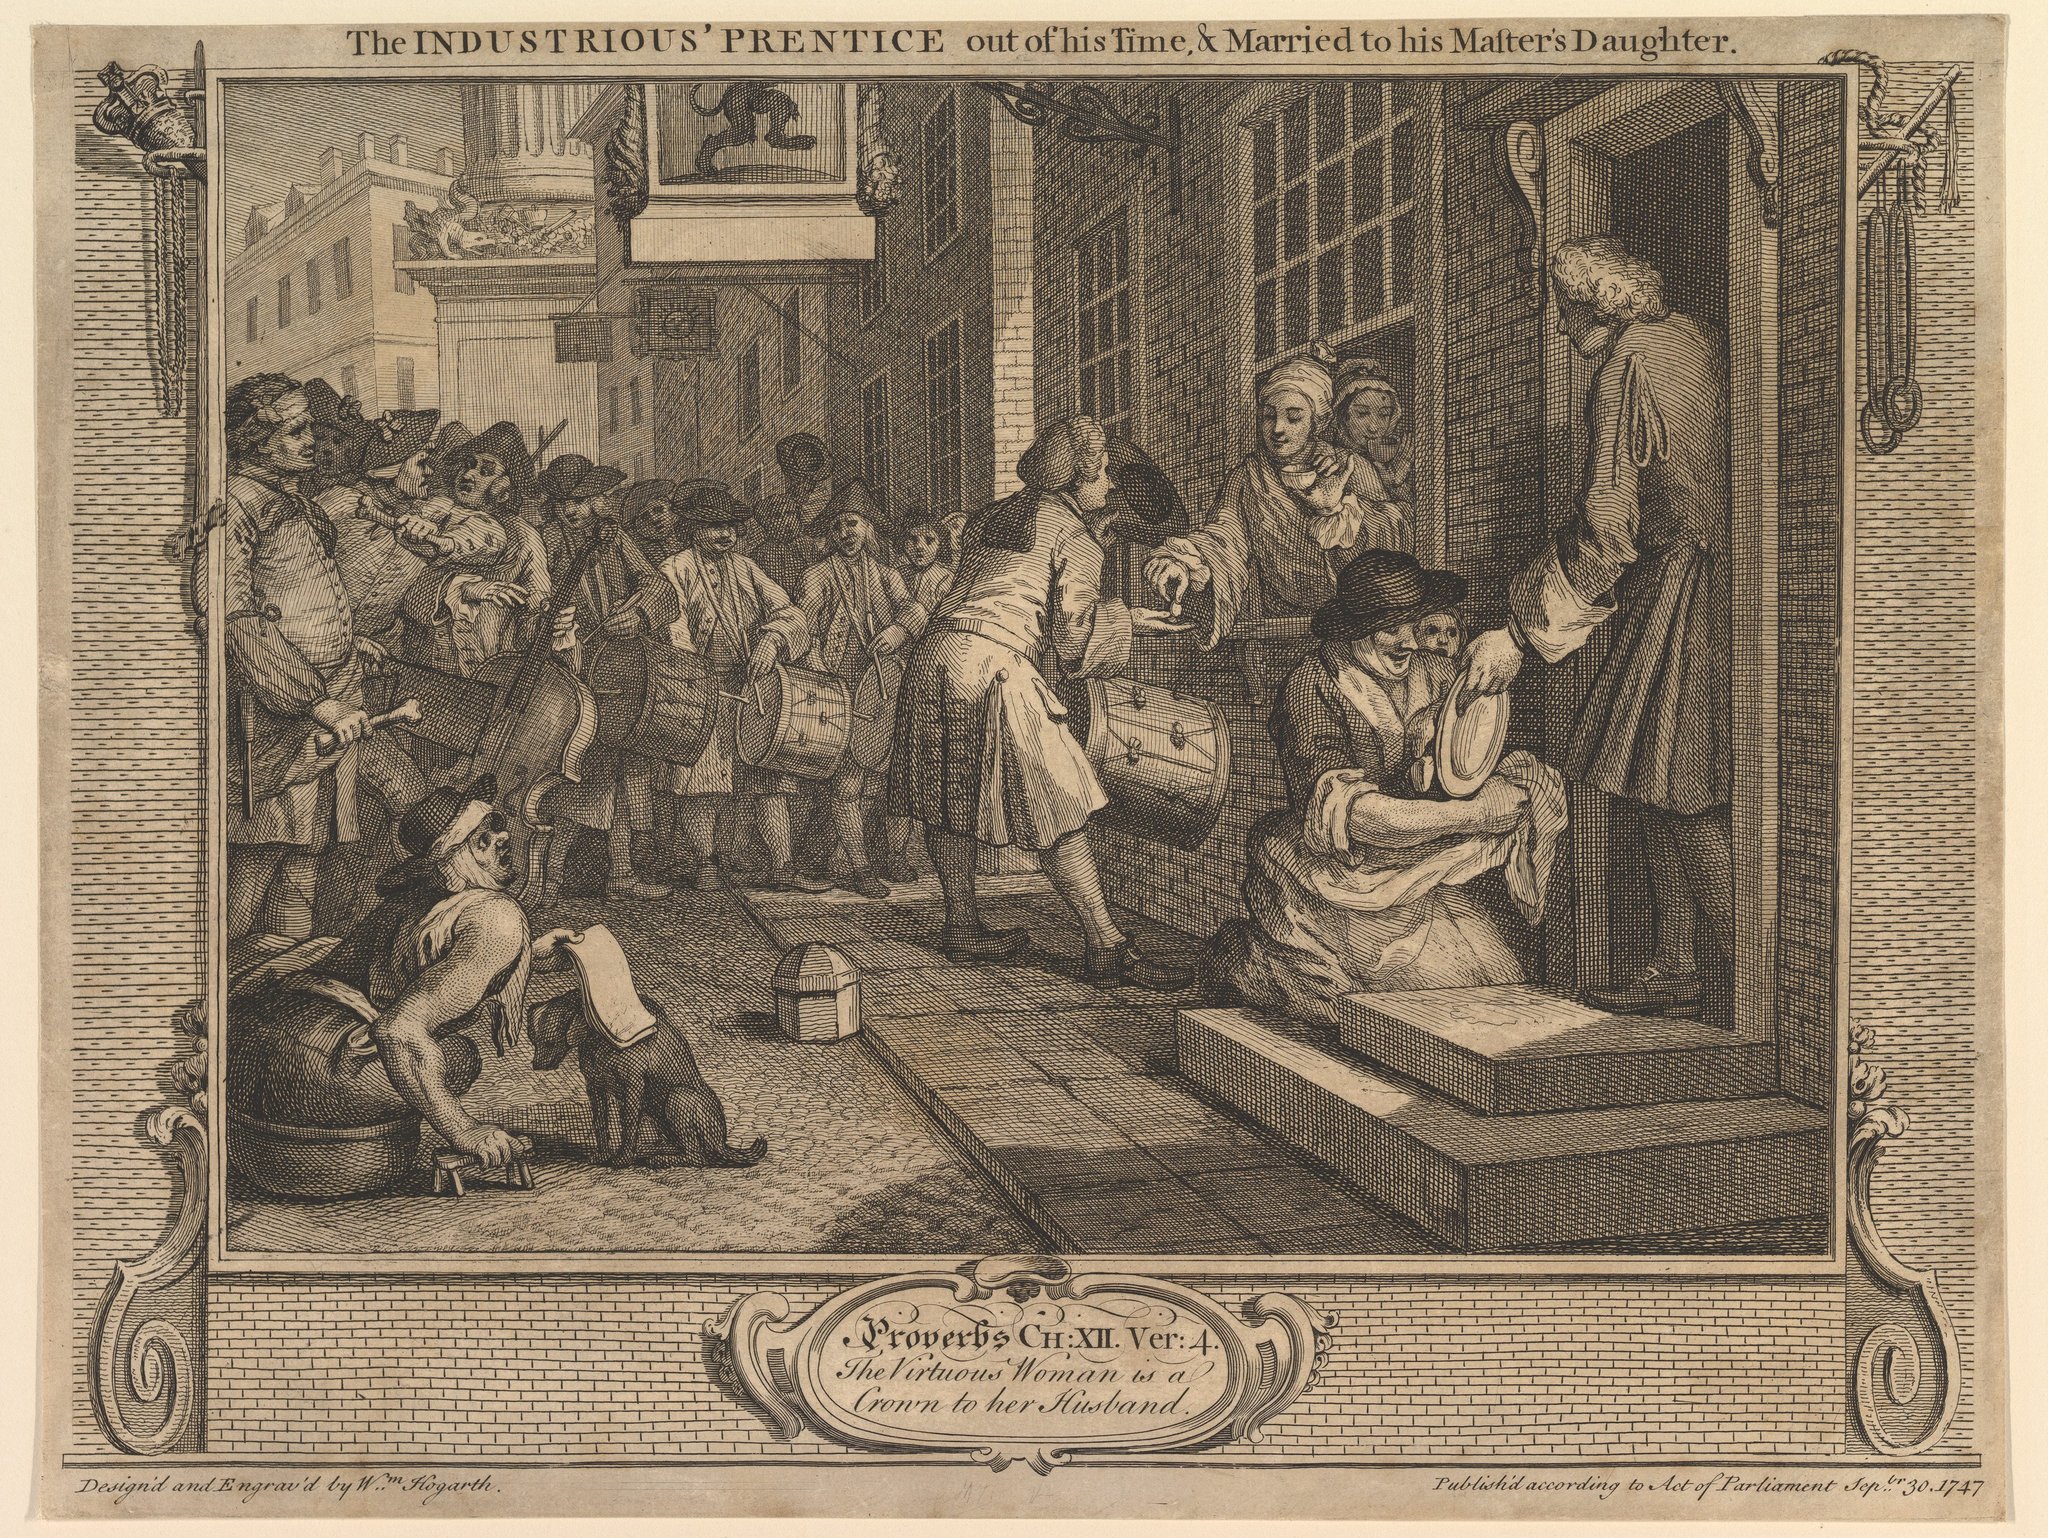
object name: print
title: The Industrious 'Prentice Out of his Time and Married to his Master's Daughter: Industry and Idleness, plate 6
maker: william hogarth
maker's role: artist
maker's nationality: british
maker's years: 1697-1764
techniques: engraving, etching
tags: musical instruments,men,women,drums,dogs